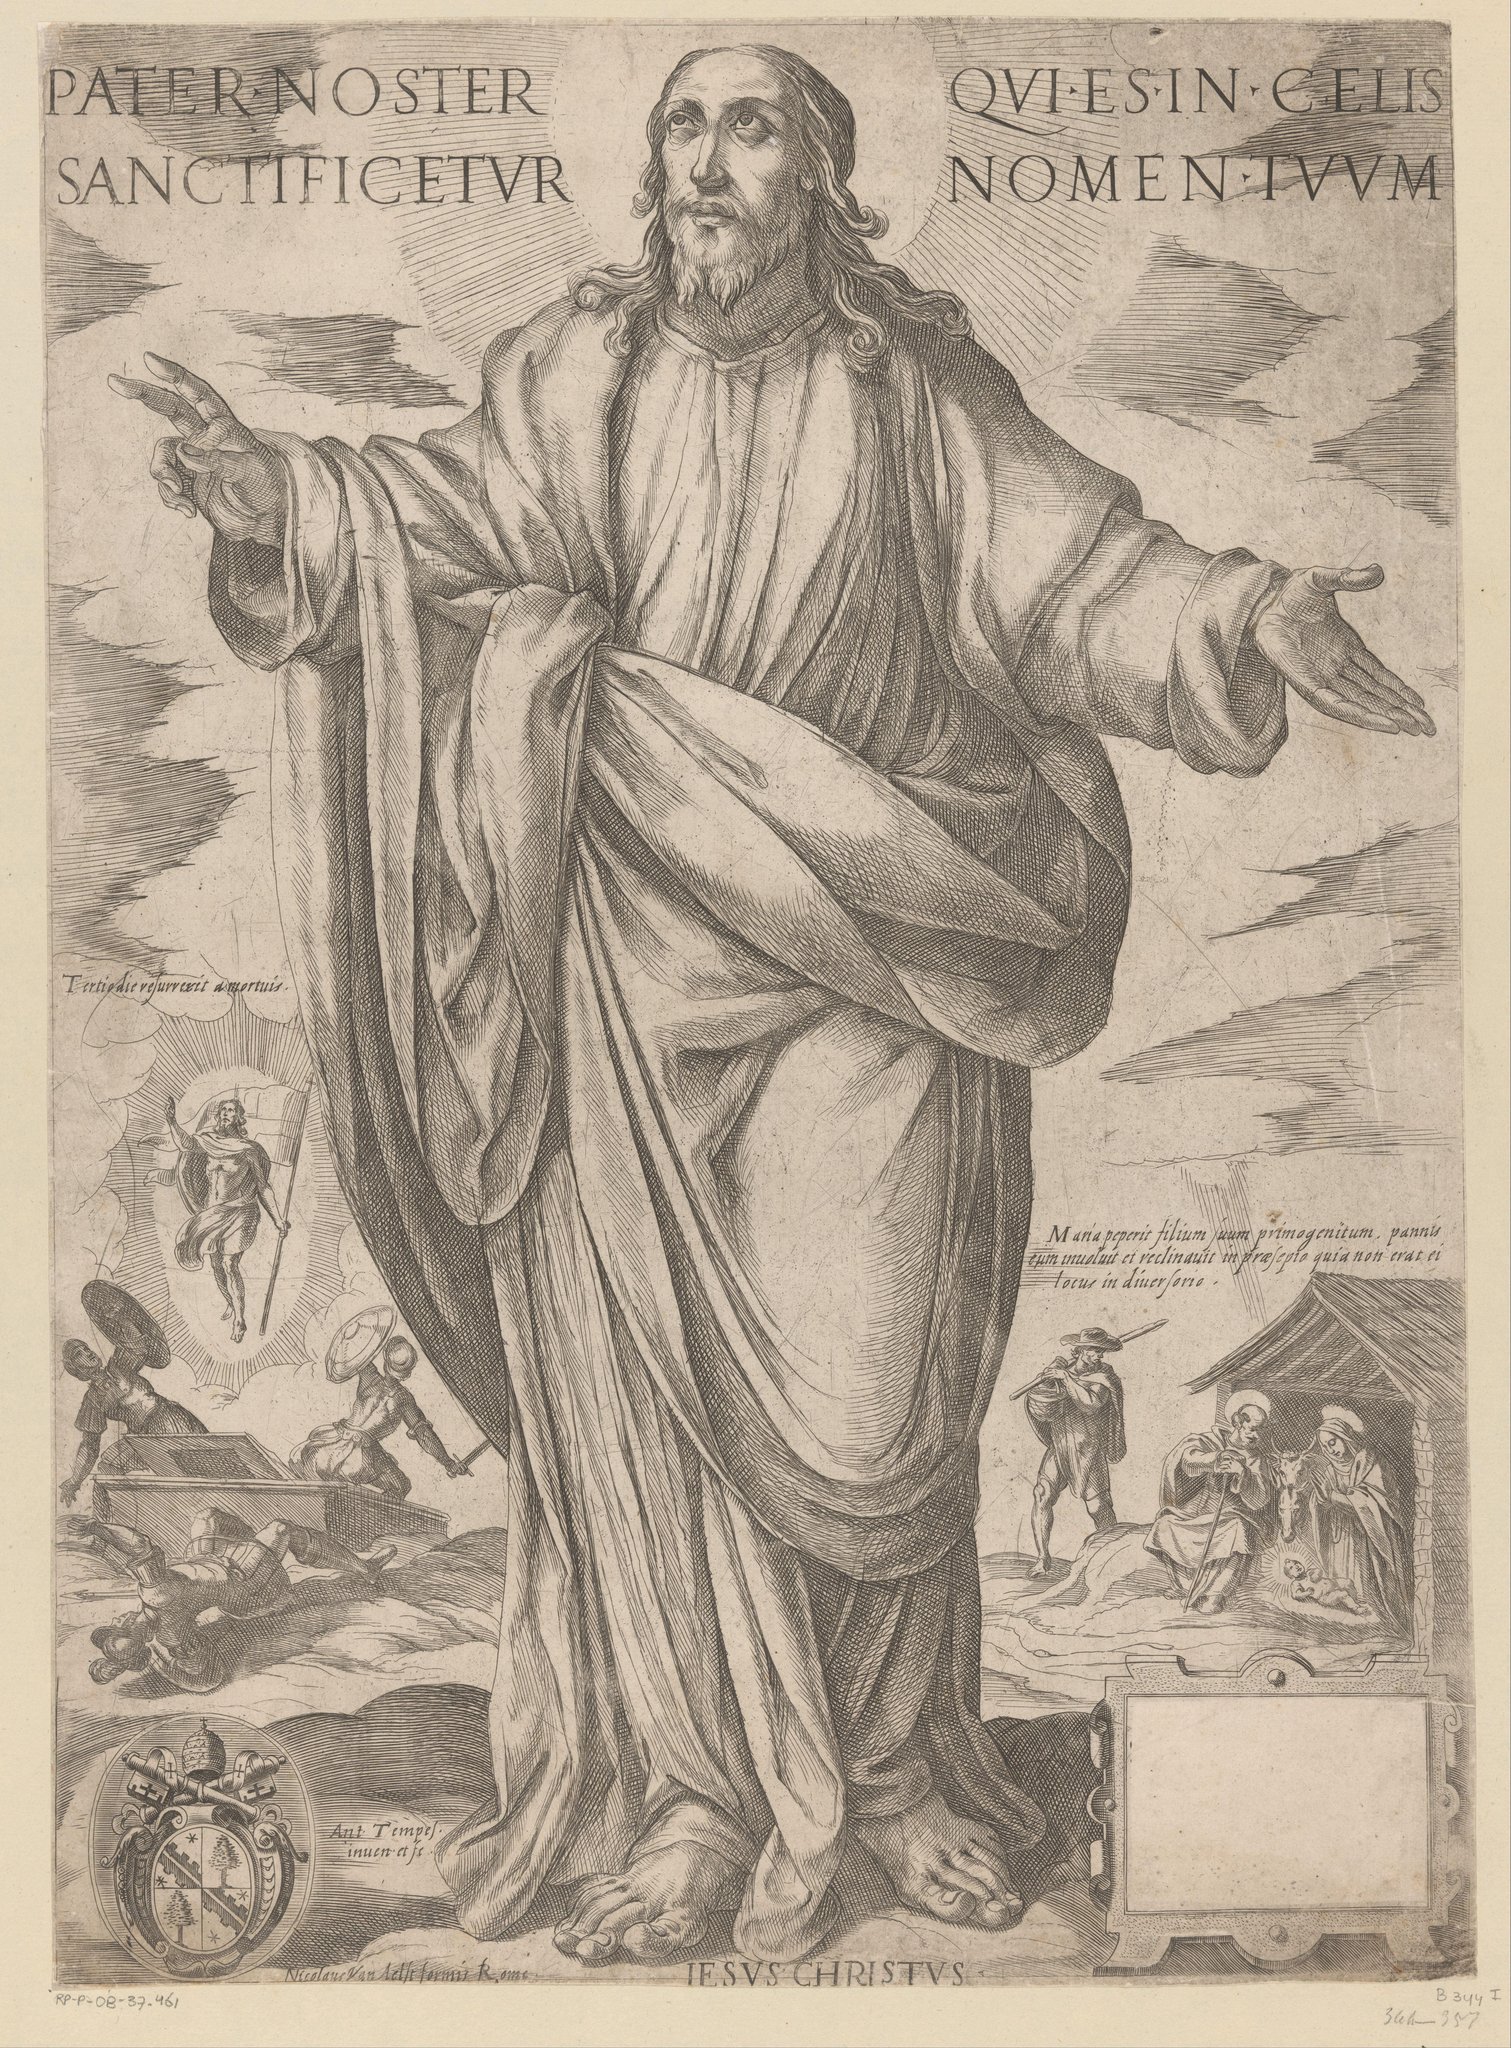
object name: print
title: Pater noster qui es in celis sanctificetur nomen tuum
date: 1565-1630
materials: paper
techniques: etching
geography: italy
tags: the ascension (christ surrounded by radiant light or in a mandorla), christ, mary, joseph and the new-born christ (nativity)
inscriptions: collector's mark: Lugt 240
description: Christus, staand, een zegenend gebaar makend. Op de achtergrond links de opstanding van Christus. Christus zweeft boven zijn graf. Op de achtergrond rechts de geboorte van Christus. Maria, Jozef, de os en de ezel zitten in een stal in aanbidding van het Christuskind. Rechtsonder een leeg cartouche.